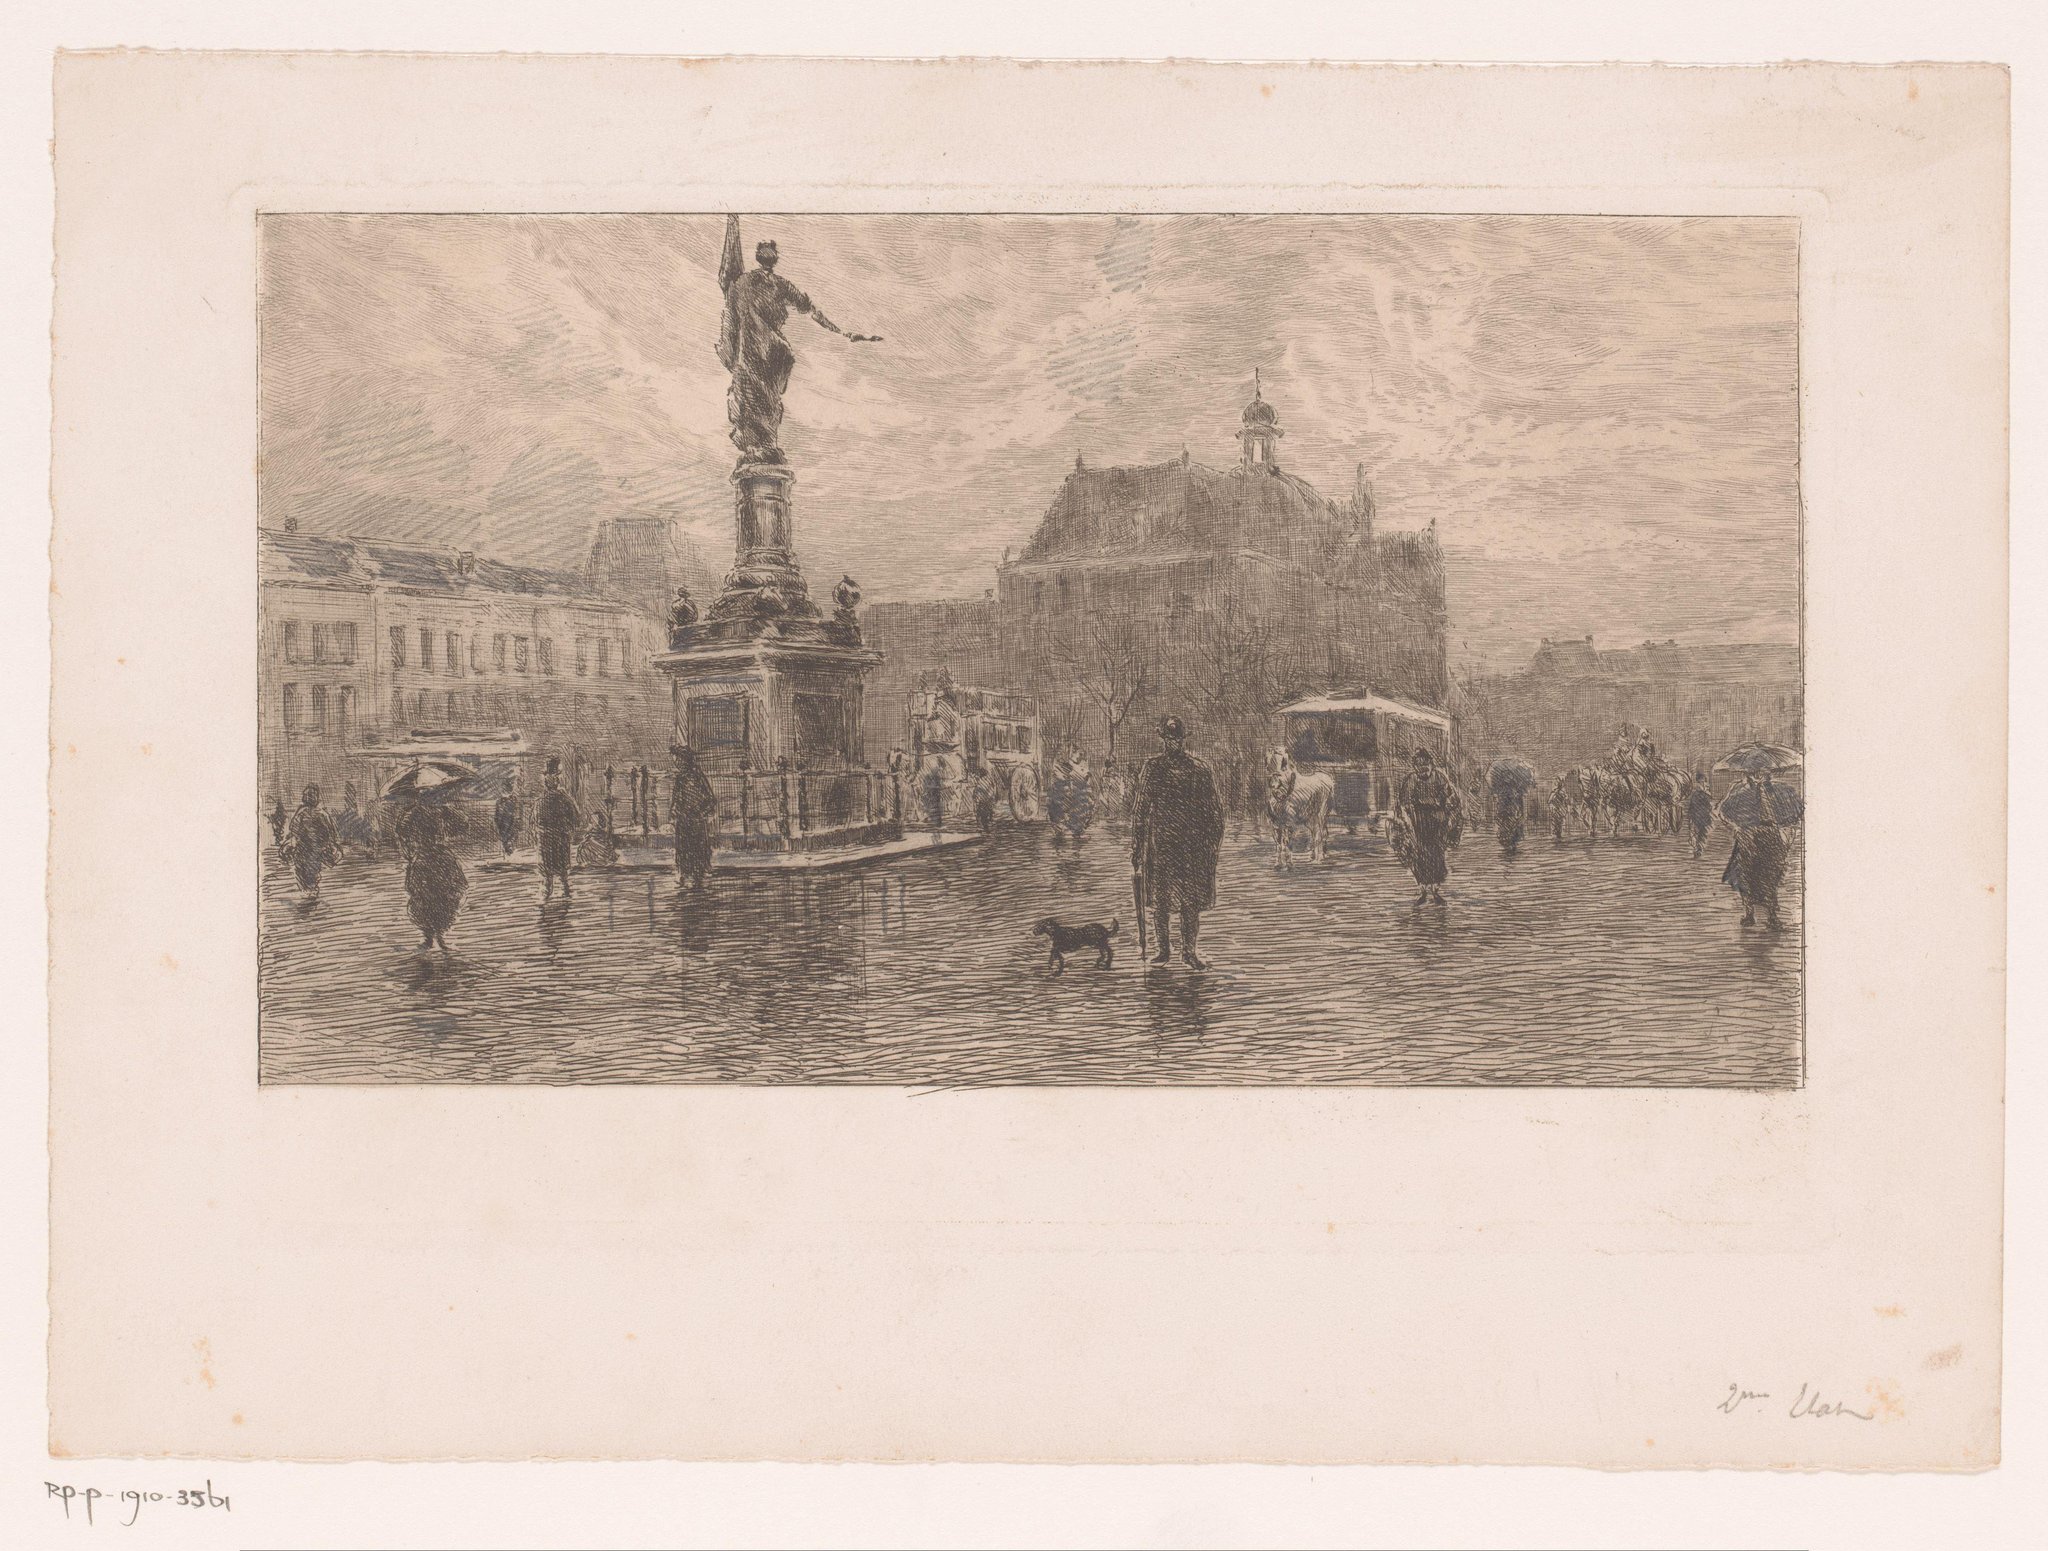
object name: print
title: Gezicht op de Place de la Commune in Antwerpen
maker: jules guiette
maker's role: print maker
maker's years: 1852-1901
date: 1862-1901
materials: paper, pencil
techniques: etching, intaglio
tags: square, place, circus, etc., monument, statue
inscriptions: annotation: ‘2me Etat’, collector's mark: Lugt 2228